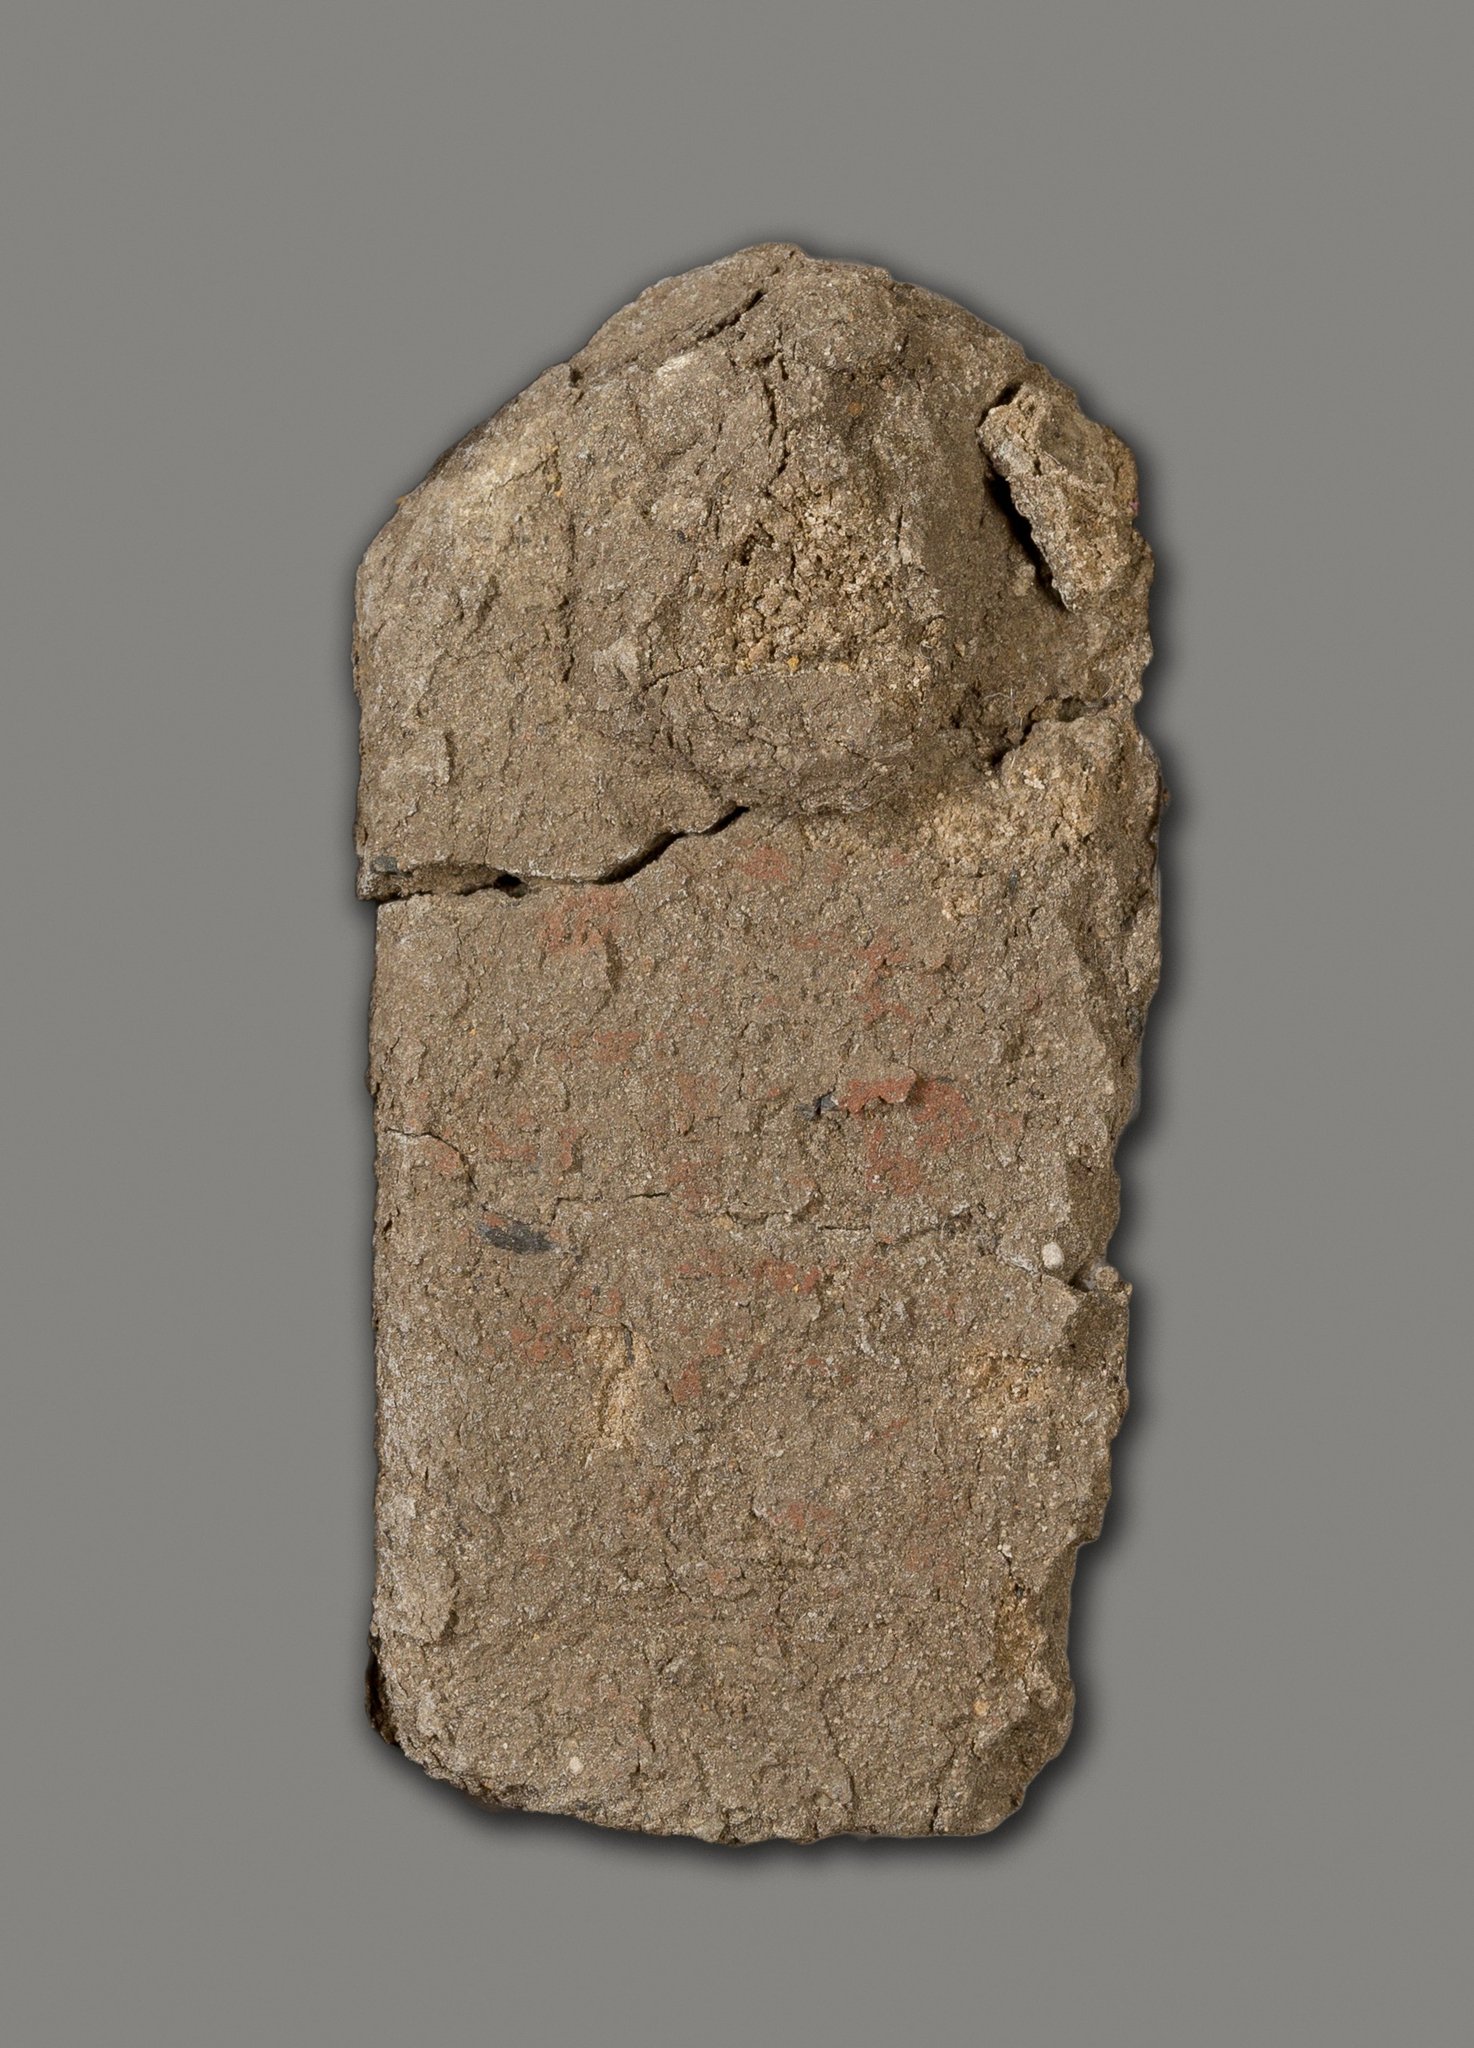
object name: figure, magical, execration, tablet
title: Magical Figure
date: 1802-1550 BCE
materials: clay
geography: egypt